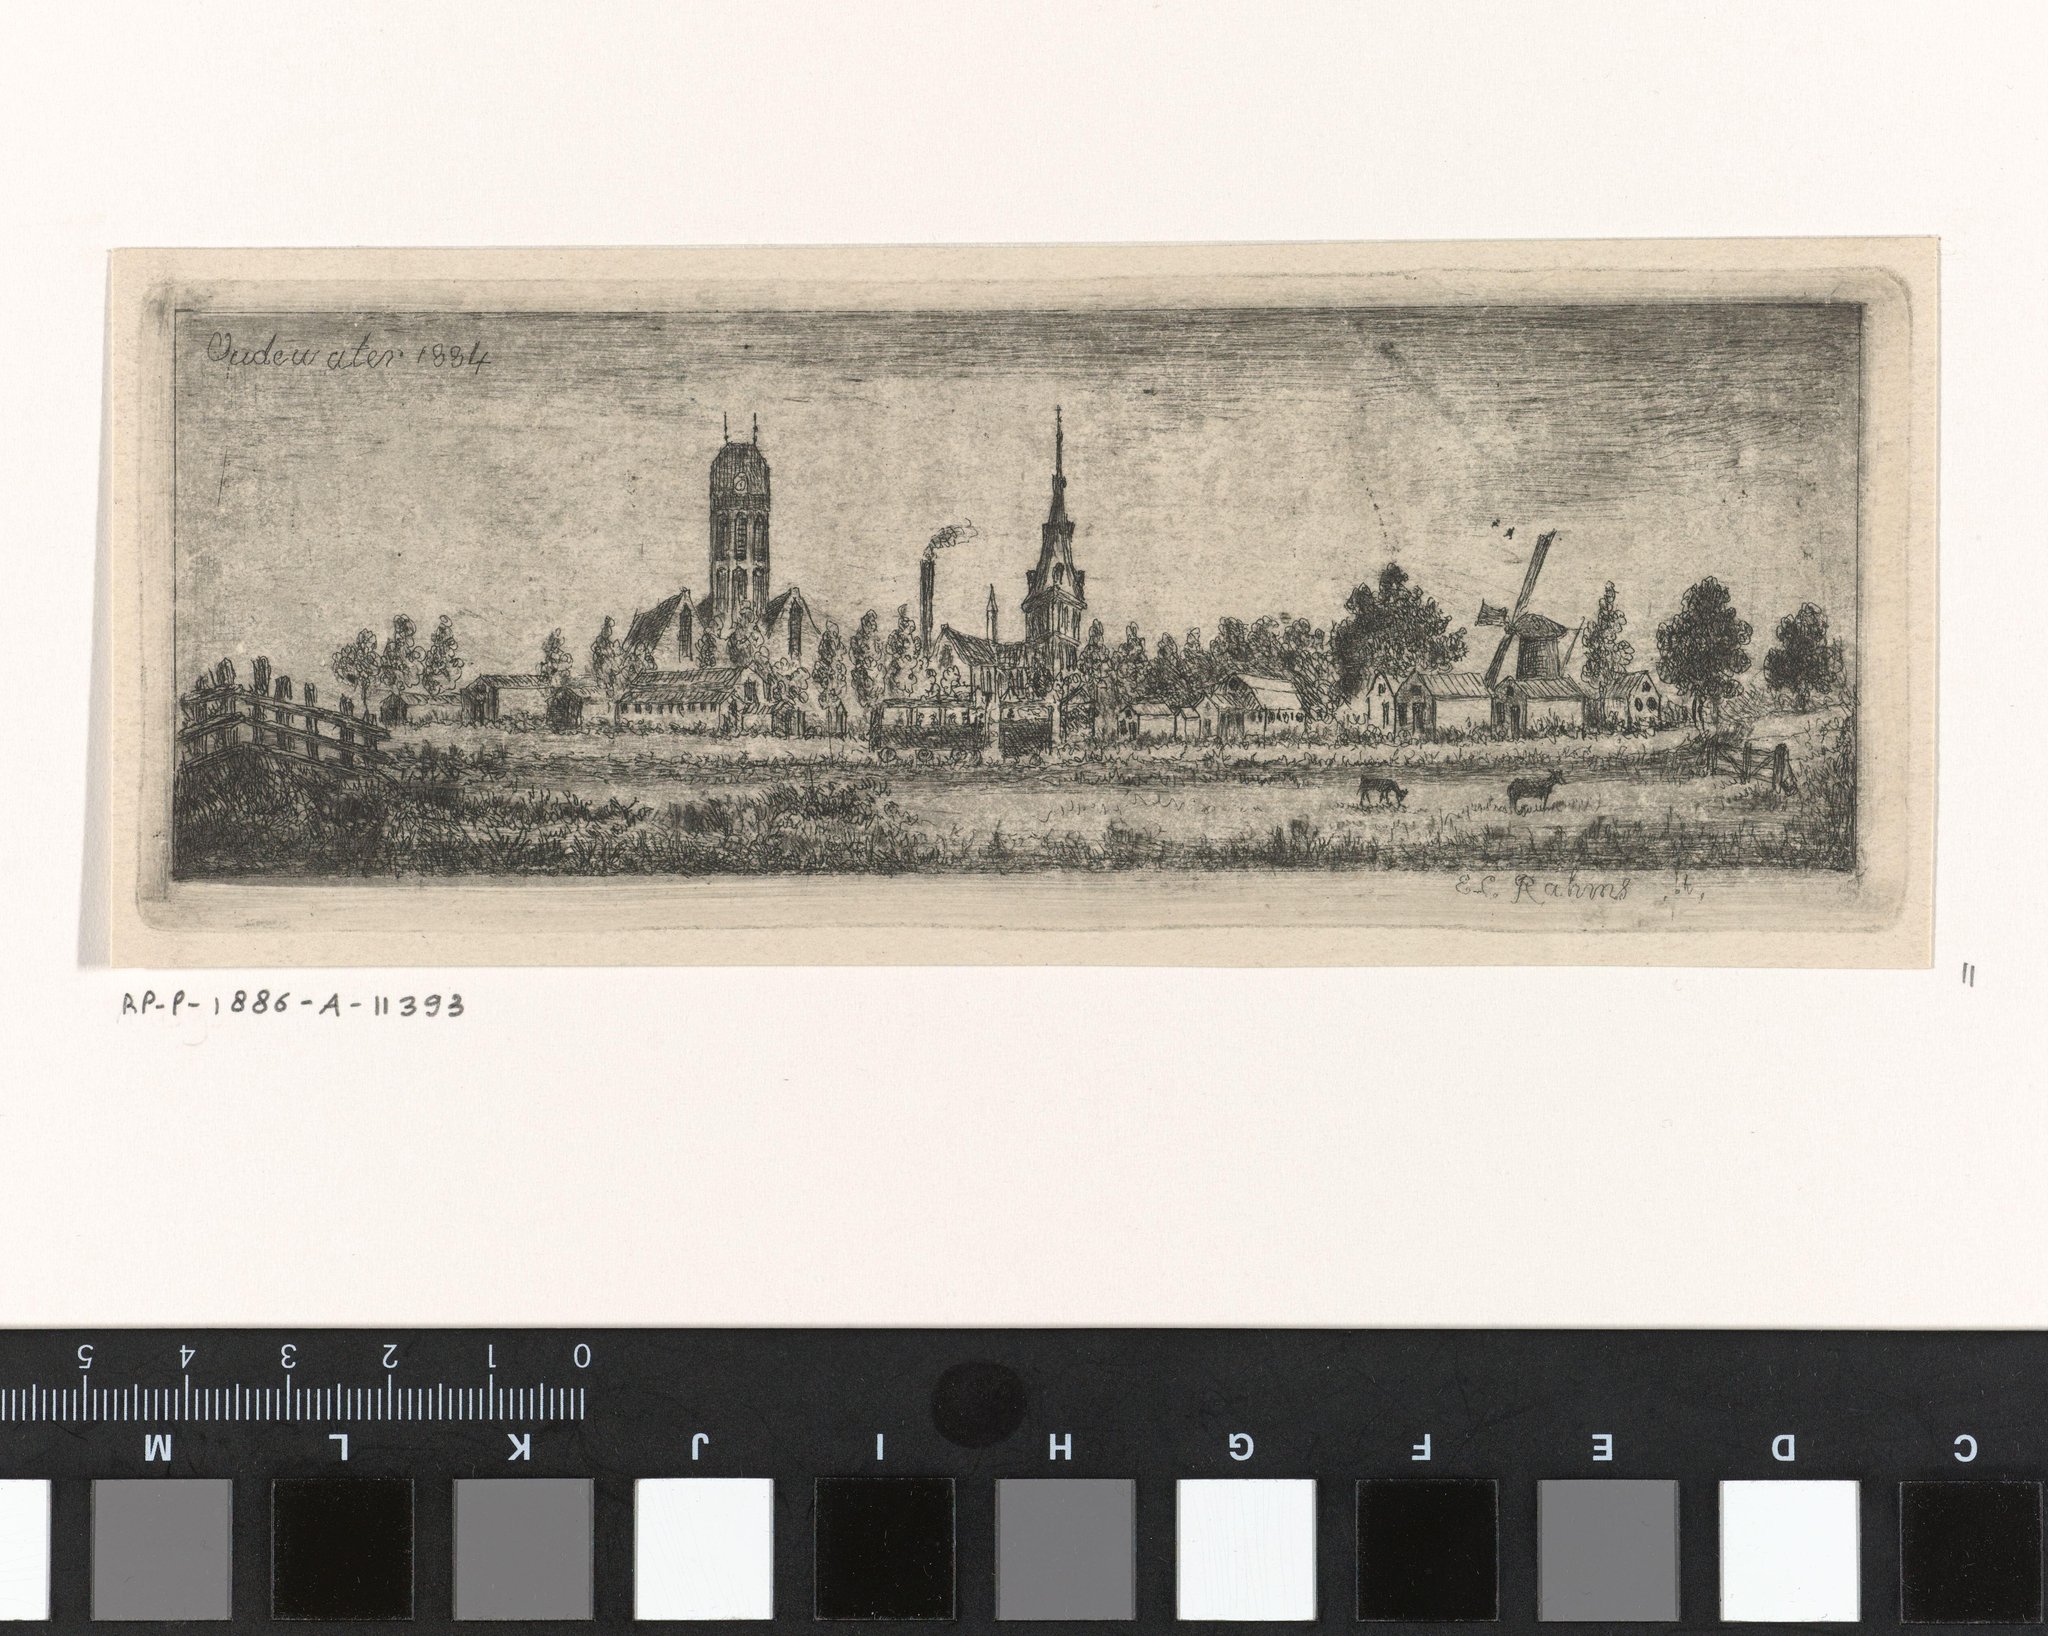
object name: print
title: Gezicht op Oudewater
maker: eberhard cornelis rahms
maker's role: print maker, publisher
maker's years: 1823-1907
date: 1884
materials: paper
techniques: drypoint, etching, intaglio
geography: oudewater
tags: church (exterior)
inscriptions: collector's mark: Lugt 2228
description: Gezicht op Oudewater met op de voorgrond weilanden en vee. Links de toren van de Sint Michaëlskerk en in het midden de toren van de Sint-Franciscuskerk.